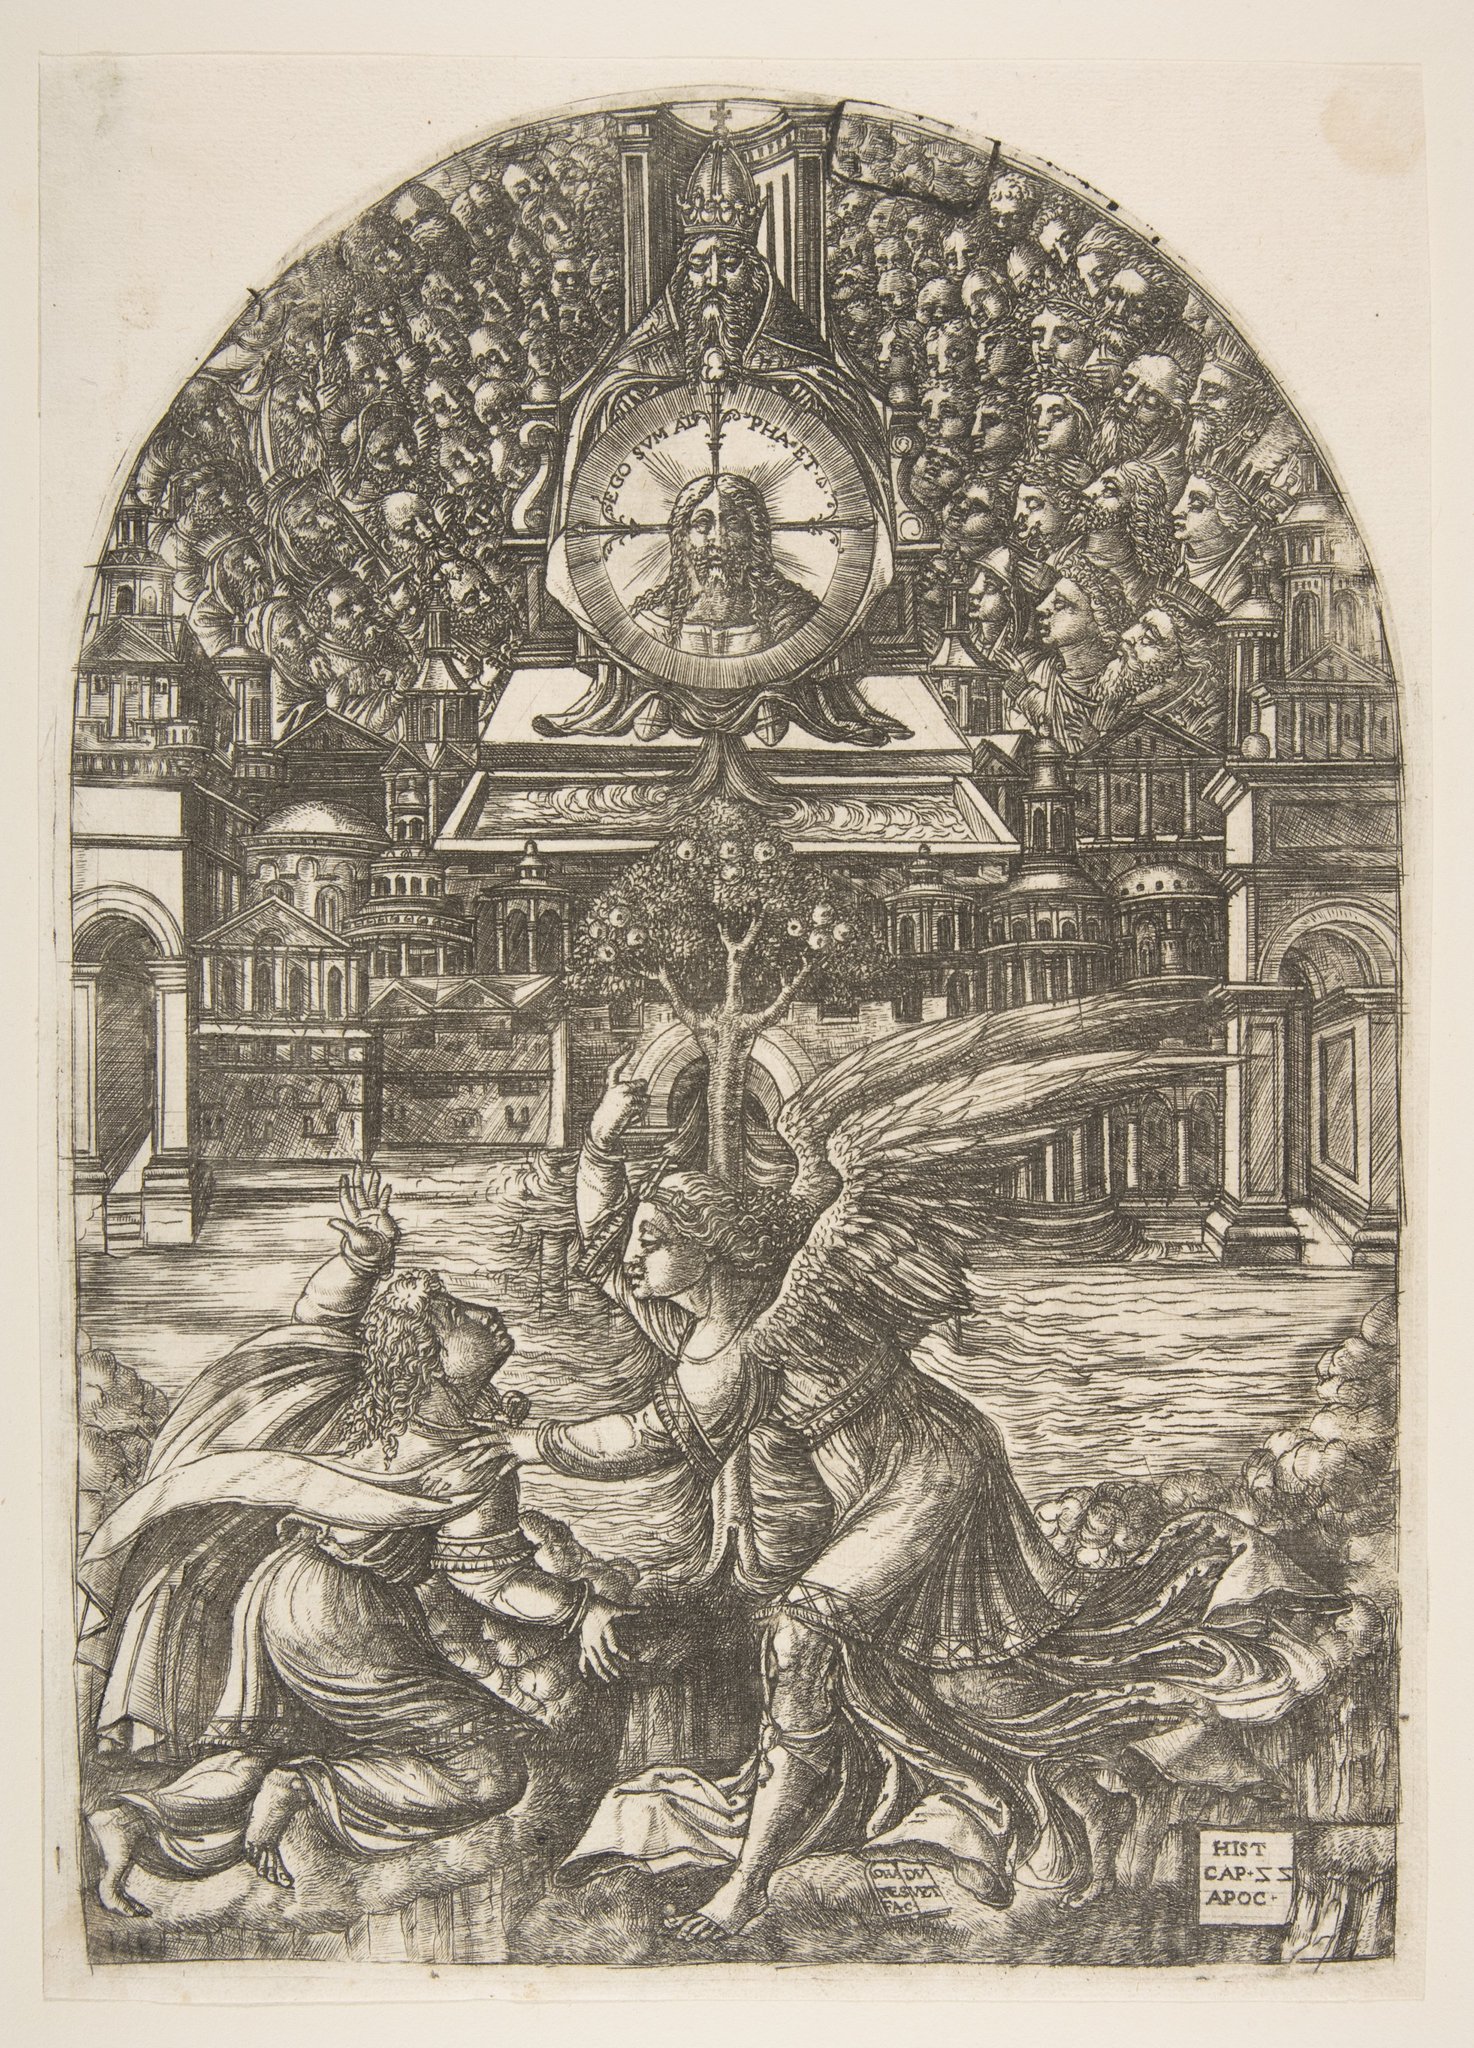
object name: print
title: The Angel shows Saint John the Fountain of Living Water, from the Apocalypse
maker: jean duvet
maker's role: artist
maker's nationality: french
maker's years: 1485-1561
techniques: engraving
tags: fountains,angels,apocalypse,saints